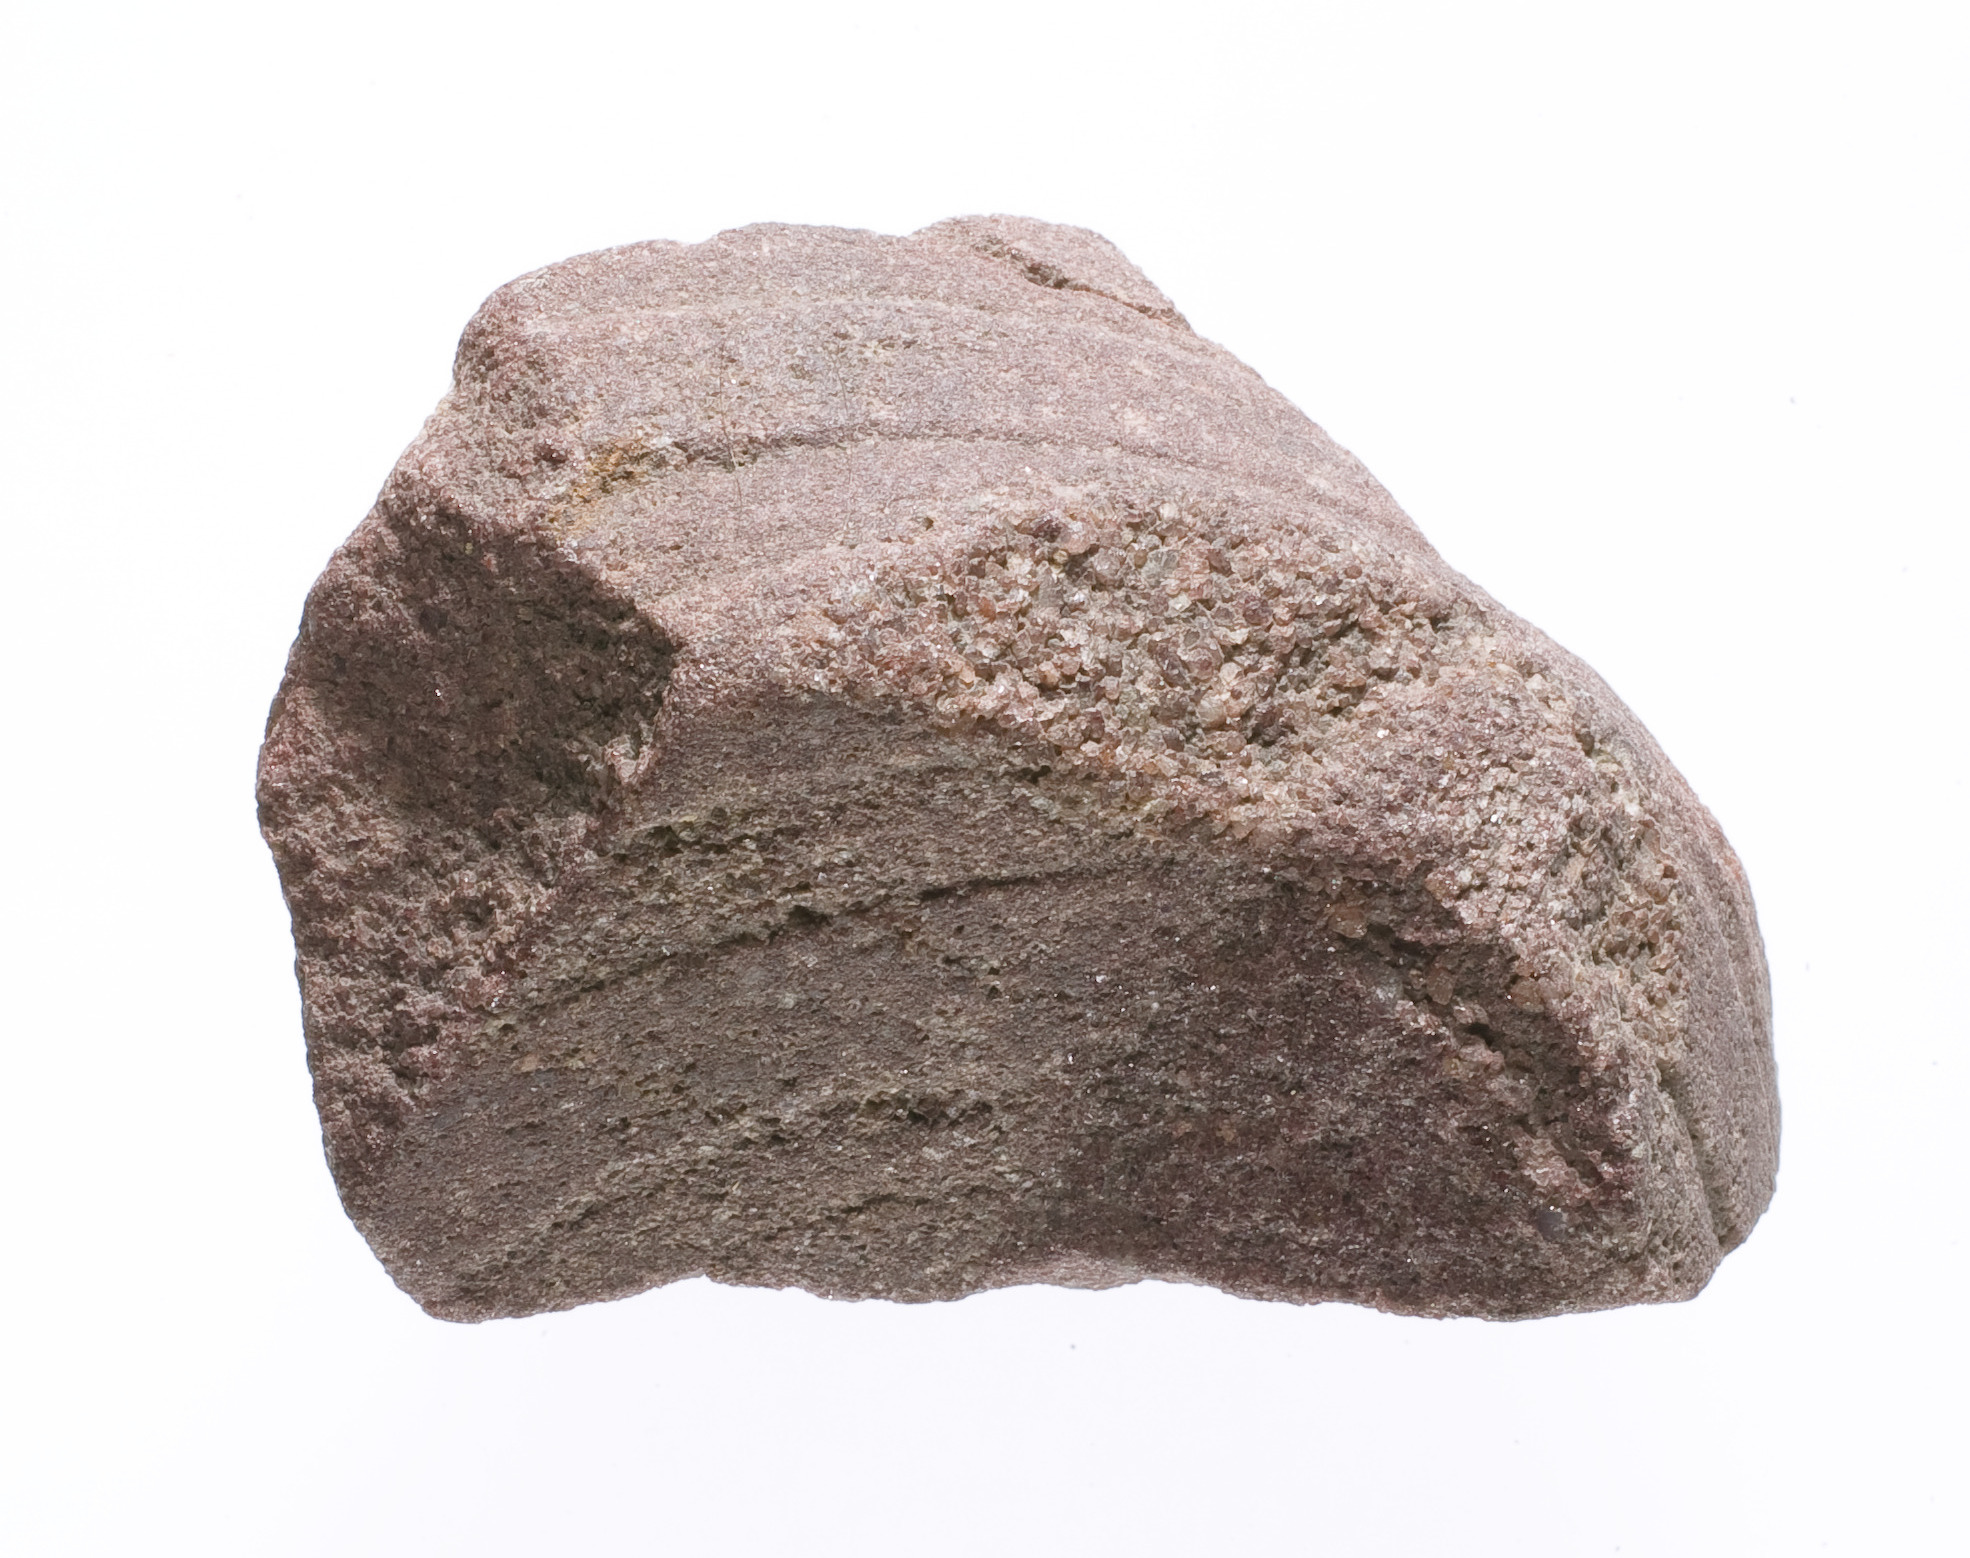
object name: nemes, 3 surface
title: Nemes fragment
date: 1353-1336 BCE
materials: quartzite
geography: egypt